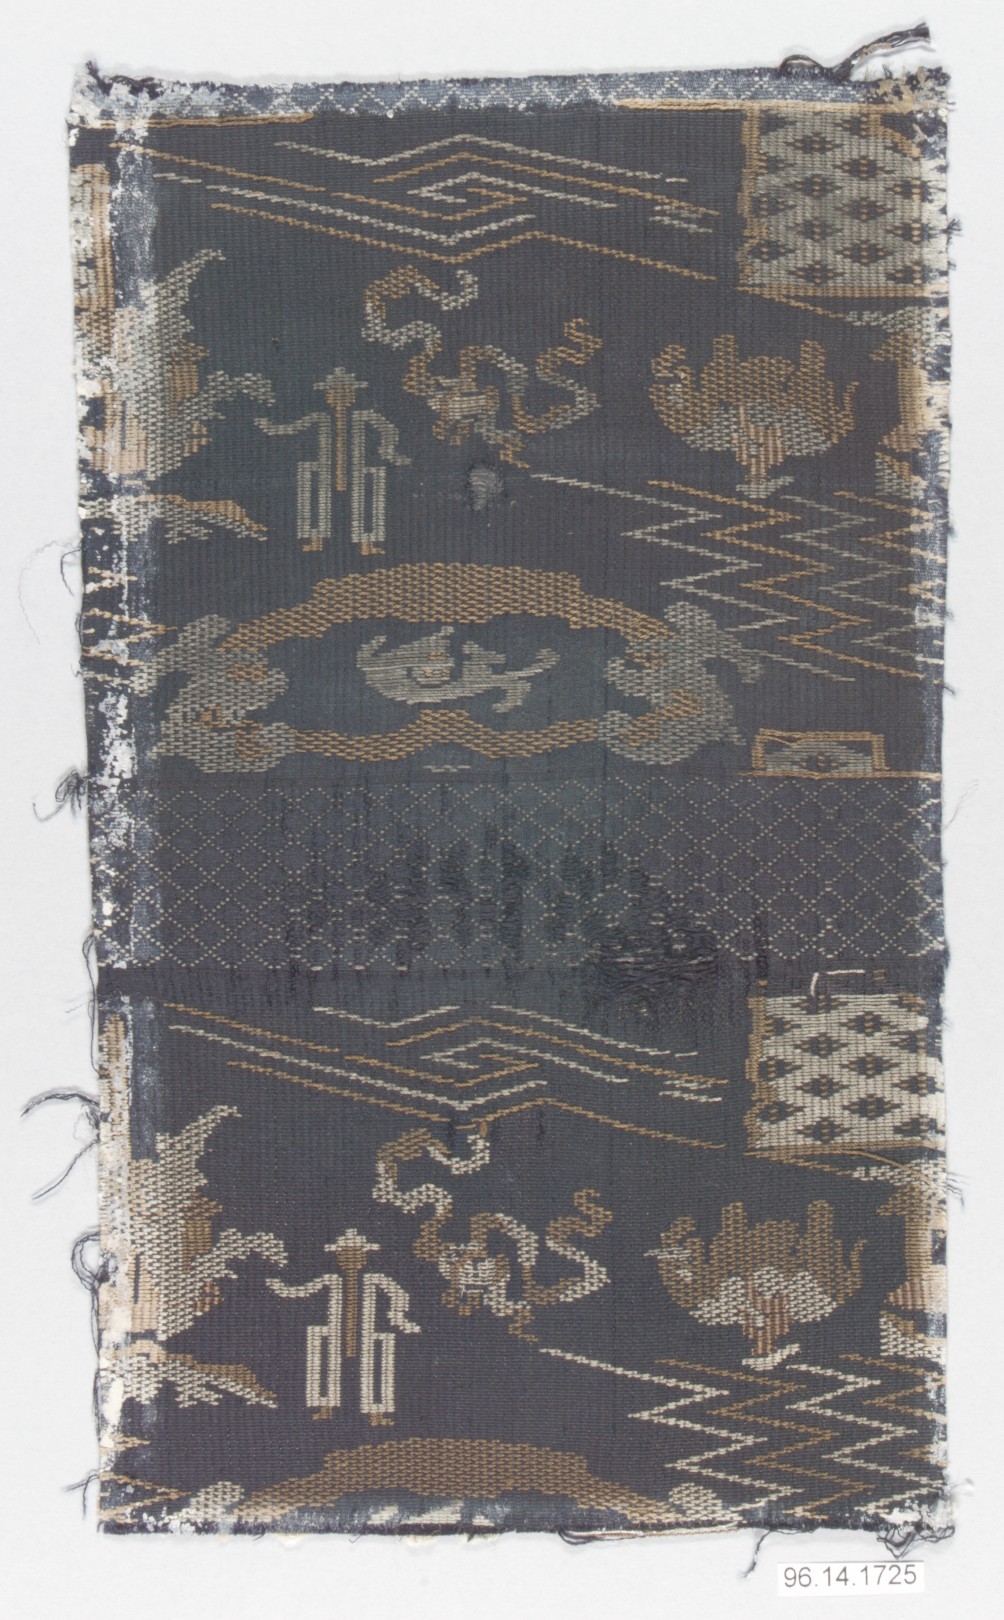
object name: piece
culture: japanese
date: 1701-1900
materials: silk